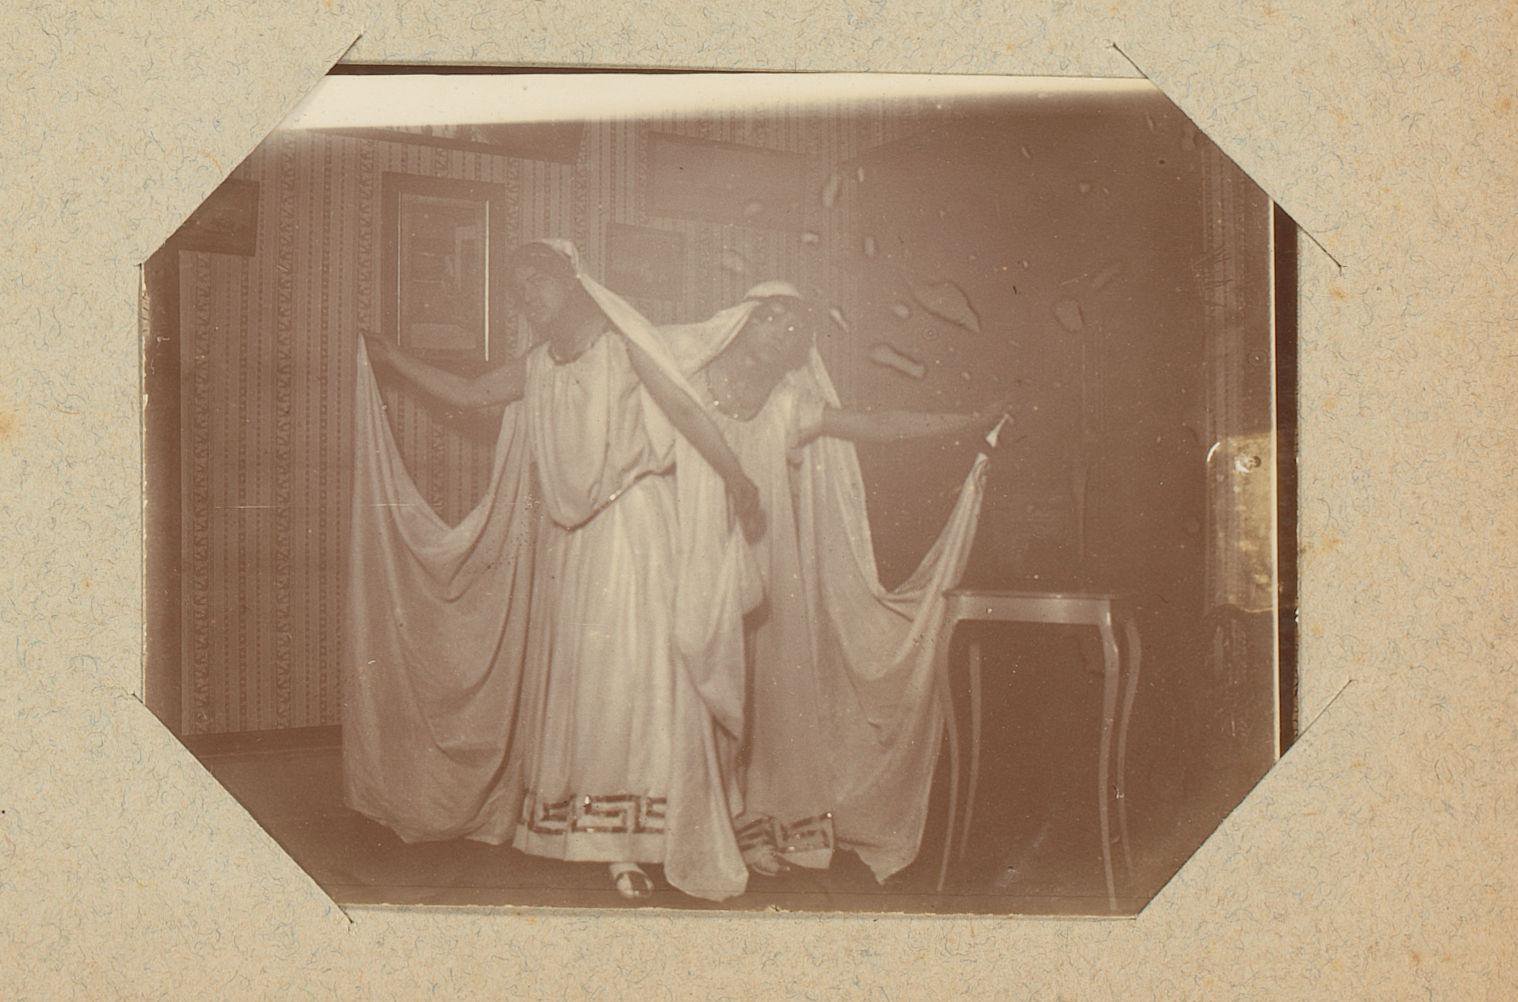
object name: album leaf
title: Portret van twee vrouwen in verkleedkleding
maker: Anonymous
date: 1897-1900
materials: paper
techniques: gelatin silver print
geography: france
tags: adult woman, historical persons, historical costume, france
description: Over de foto is een ander negatief afgedrukt van een voorstelling van bomen.